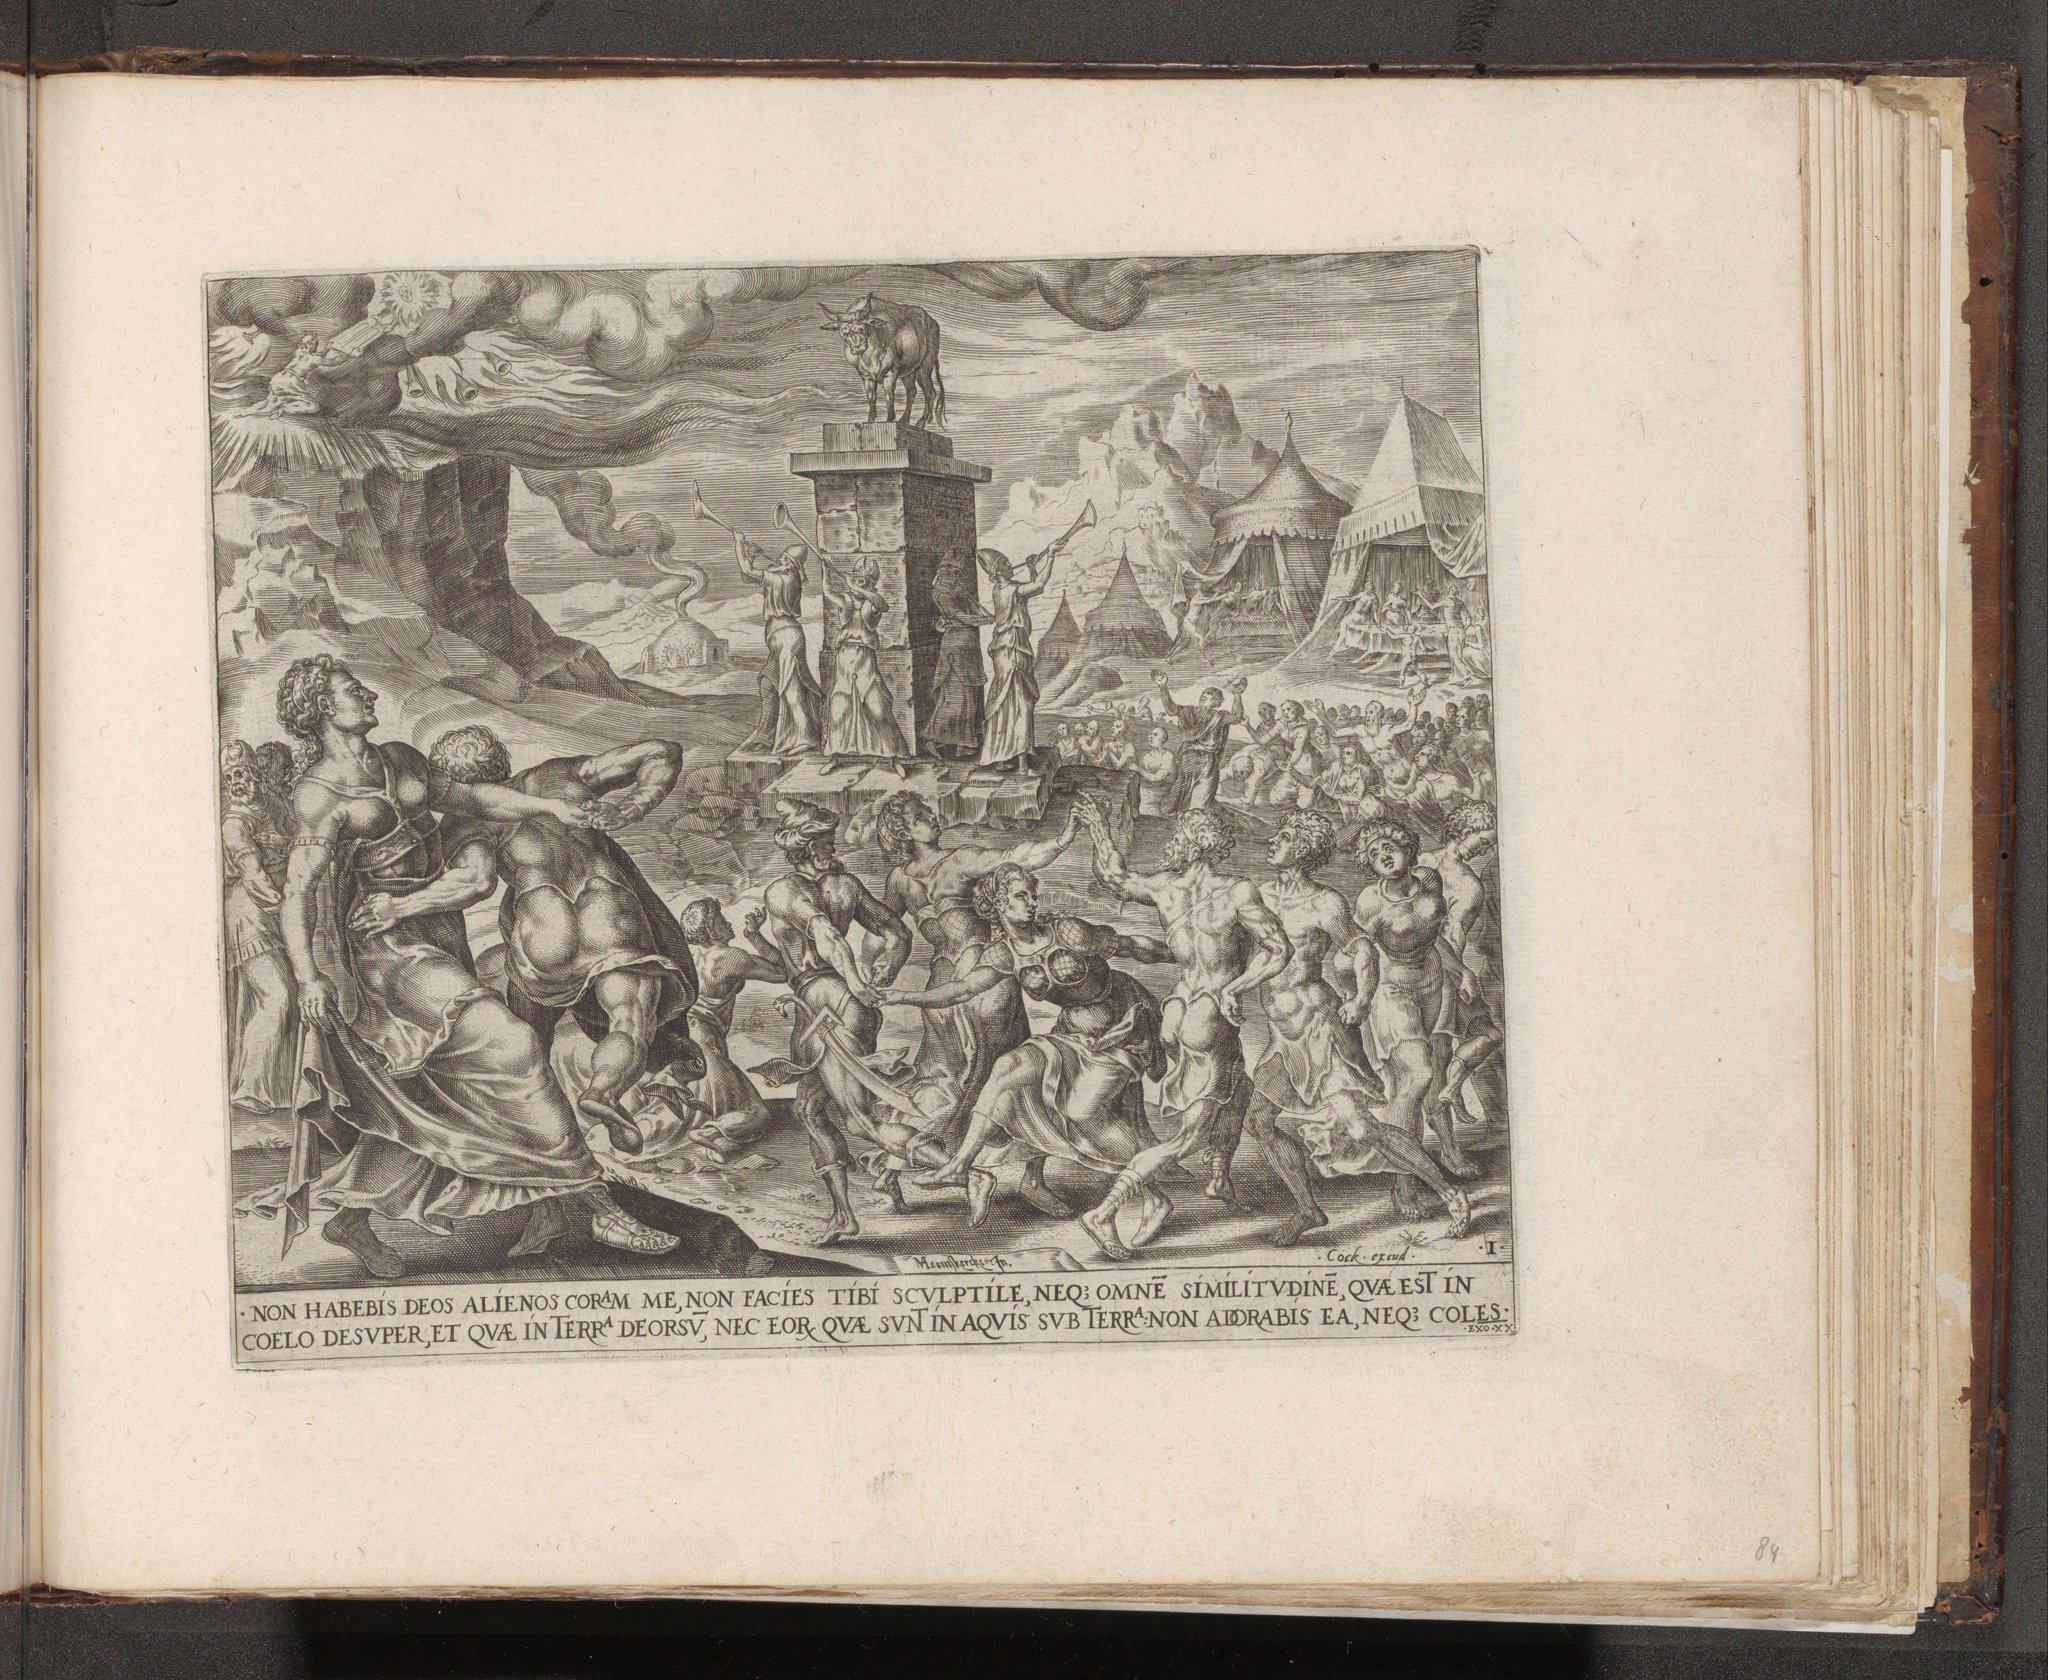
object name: album leaf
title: Thesaurus sacrarum historiaru[m] veteris testame[n]ti, elega[n]tissimis imaginibus expressu[m] excelle[n]tissimoru[m] in hac arte viroru[m] opera: nu[n]c primu[m] in luce[m] editus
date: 1564-1568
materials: paper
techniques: engraving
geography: amsterdam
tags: 'you shall have no other gods' ~ separate representation of the first of the ten commandments, the people dance around the golden calf ~ exodus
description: De Israëlieten dansen rond het gouden kalf, terwijl Mozes op de berg de tien geboden van God ontvangt. Prent maakt deel uit van een serie over de tien geboden en geeft een overtreding van het eerste gebod weer: Gij zult geen andere goden voor mijn aangezicht hebben. Onderaan in de marge een verwijzing naar de Bijbeltekst in het Latijn. Prent maakt deel uit van een album.